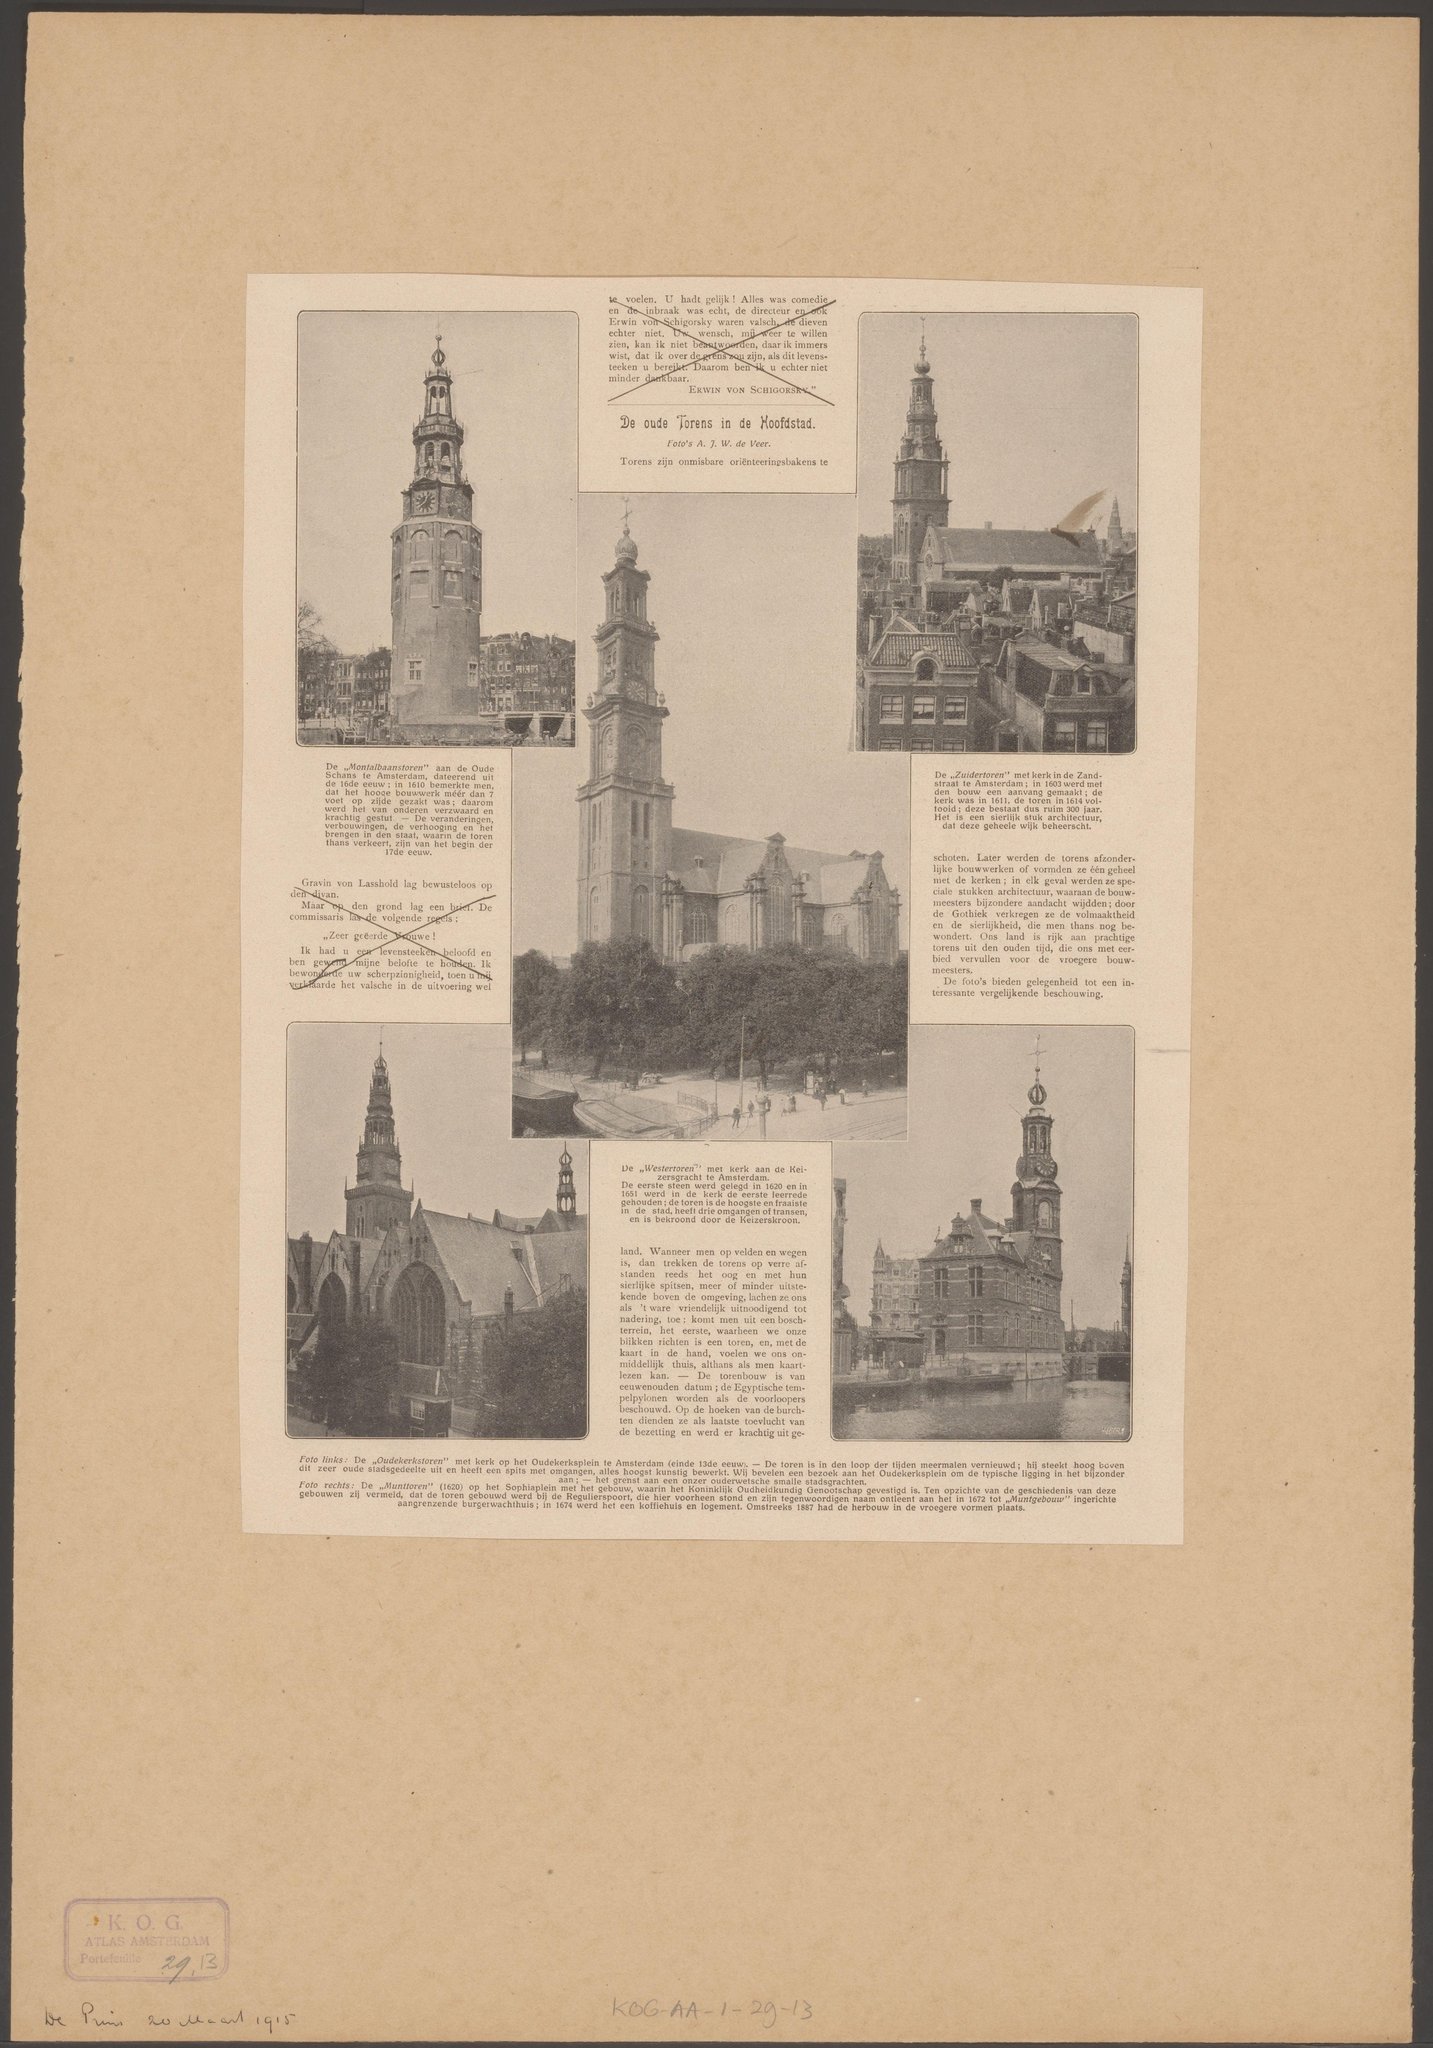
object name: photomechanical print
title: De oude Torens in de Hoofdstad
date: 1915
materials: paper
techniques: letterpress printing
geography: amsterdam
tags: tower, clock tower ~ monumental adornment, church (exterior)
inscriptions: collector's mark: Lugt 1641b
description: Individuele opnames van de Montelbaanstoren, Zuidertoren, Westertoren, Oudekerkstoren en Munttoren te Amsterdam. Onderwerpsrubriek binnen de Atlas Amsterdam: Torens, verzamelbladen.